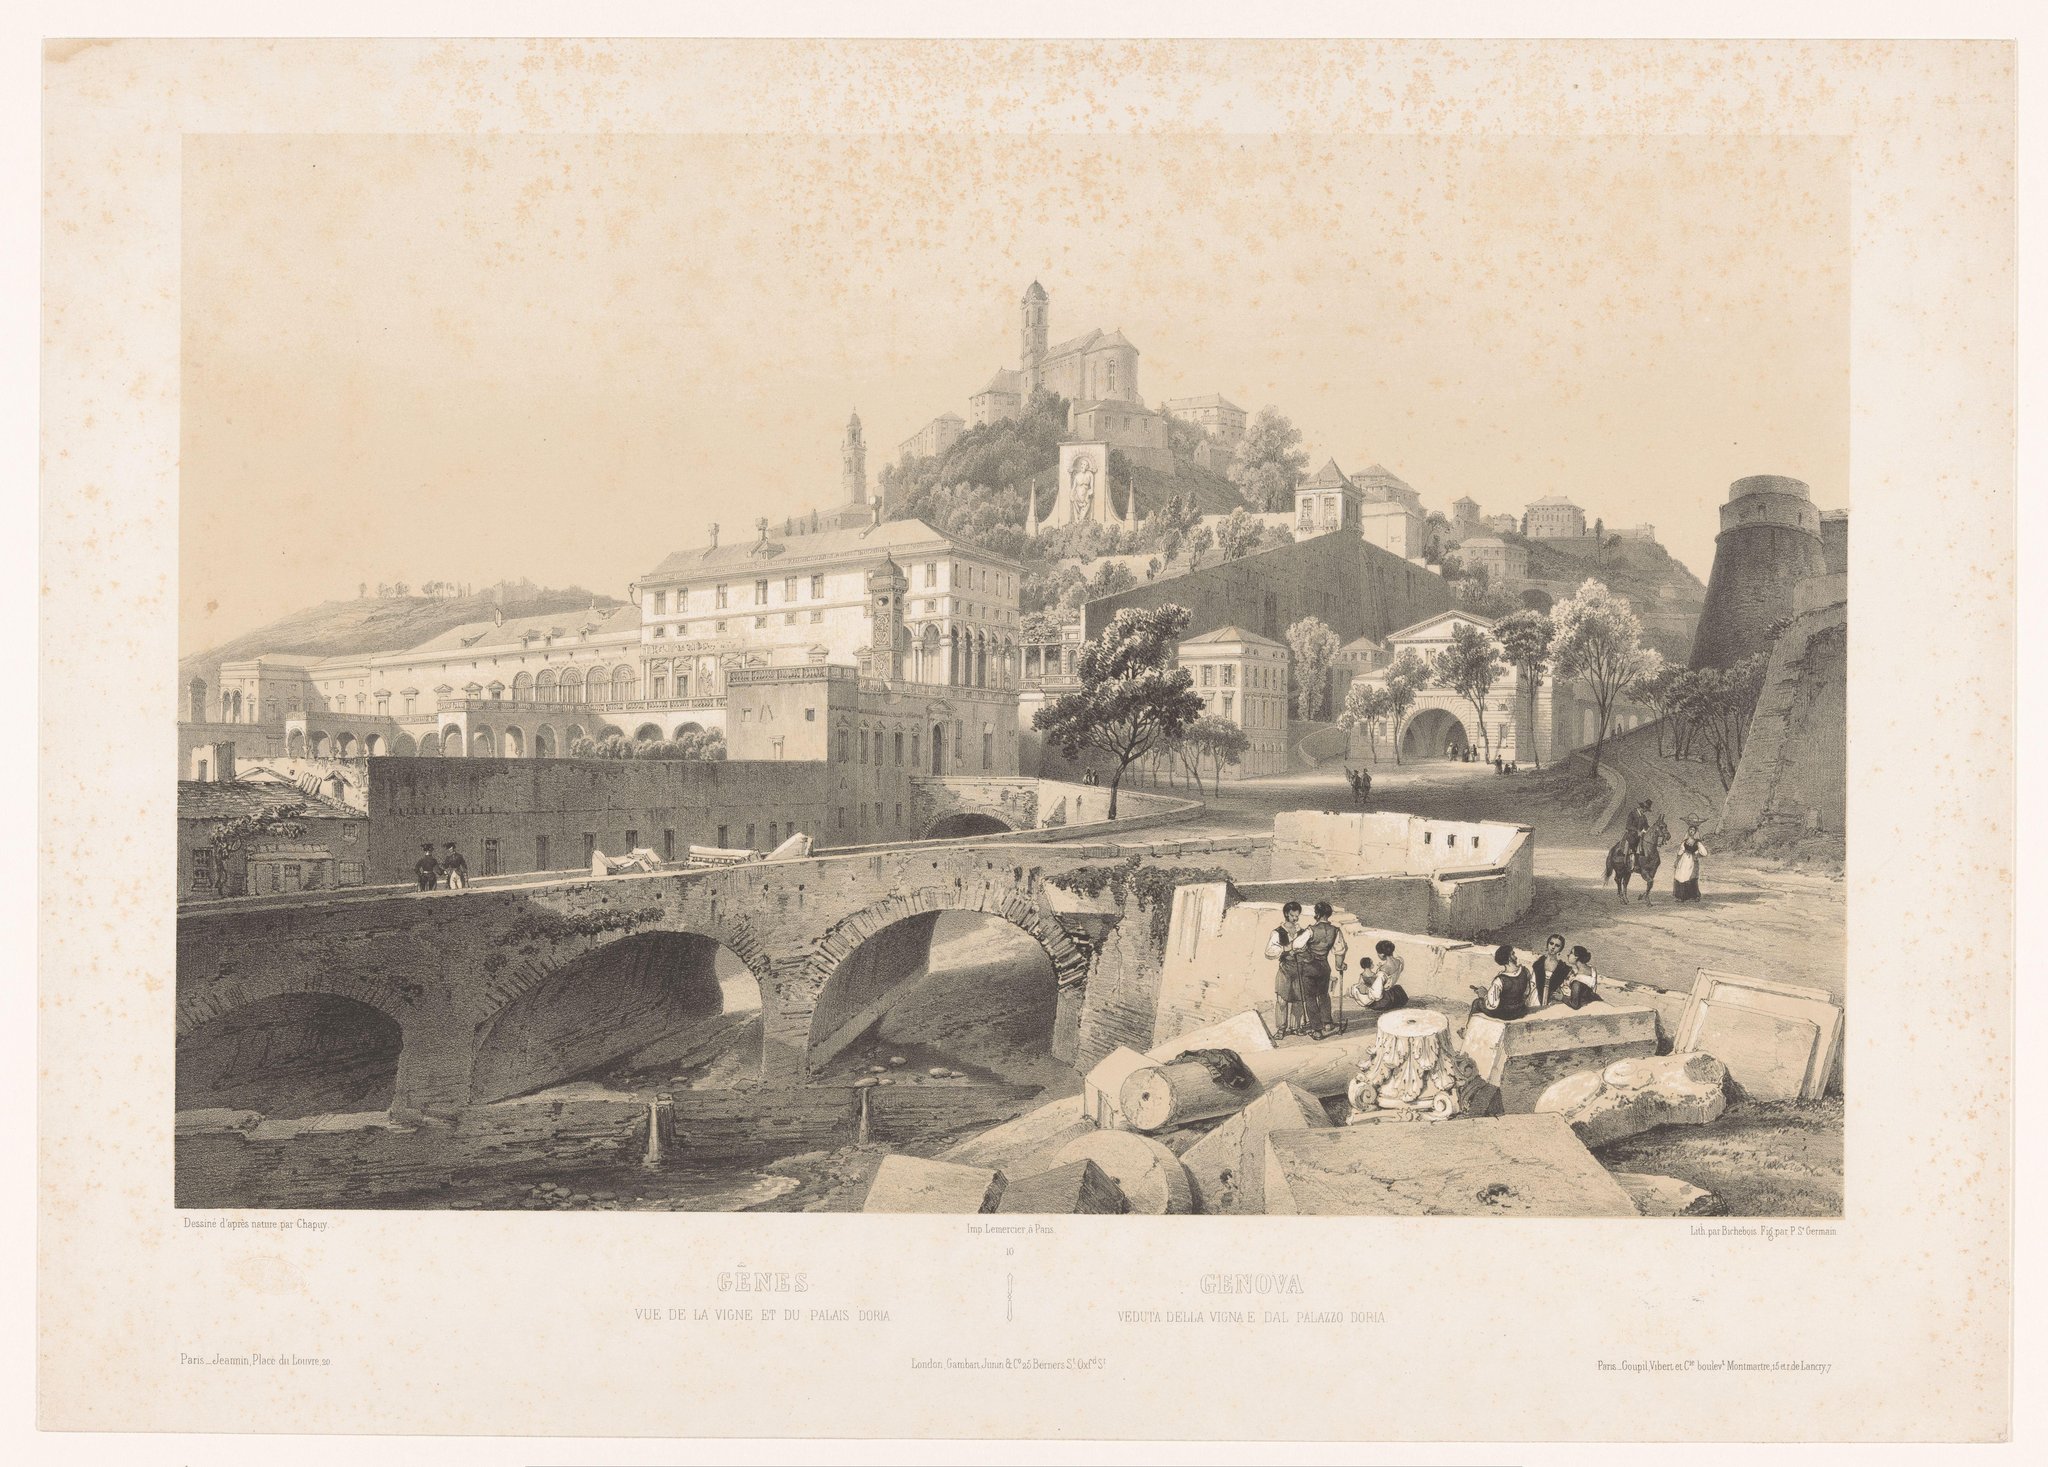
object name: print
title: Zicht op het Palazzo Doria in Genua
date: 1841-1850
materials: paper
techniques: tone lithography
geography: paris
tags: hôtel, i.e. small palace in city, landscape with ruins (+ city(-scape) with figures, staffage), prospect of city, town panorama, silhouette of city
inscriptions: check stamp: Lugt 5004, collector's mark: Lugt 2228, check stamp: Lugt 1397c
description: Op de voorgrond staan en zitten diverse figuren tussen brokstukken van antieke gebouwen.